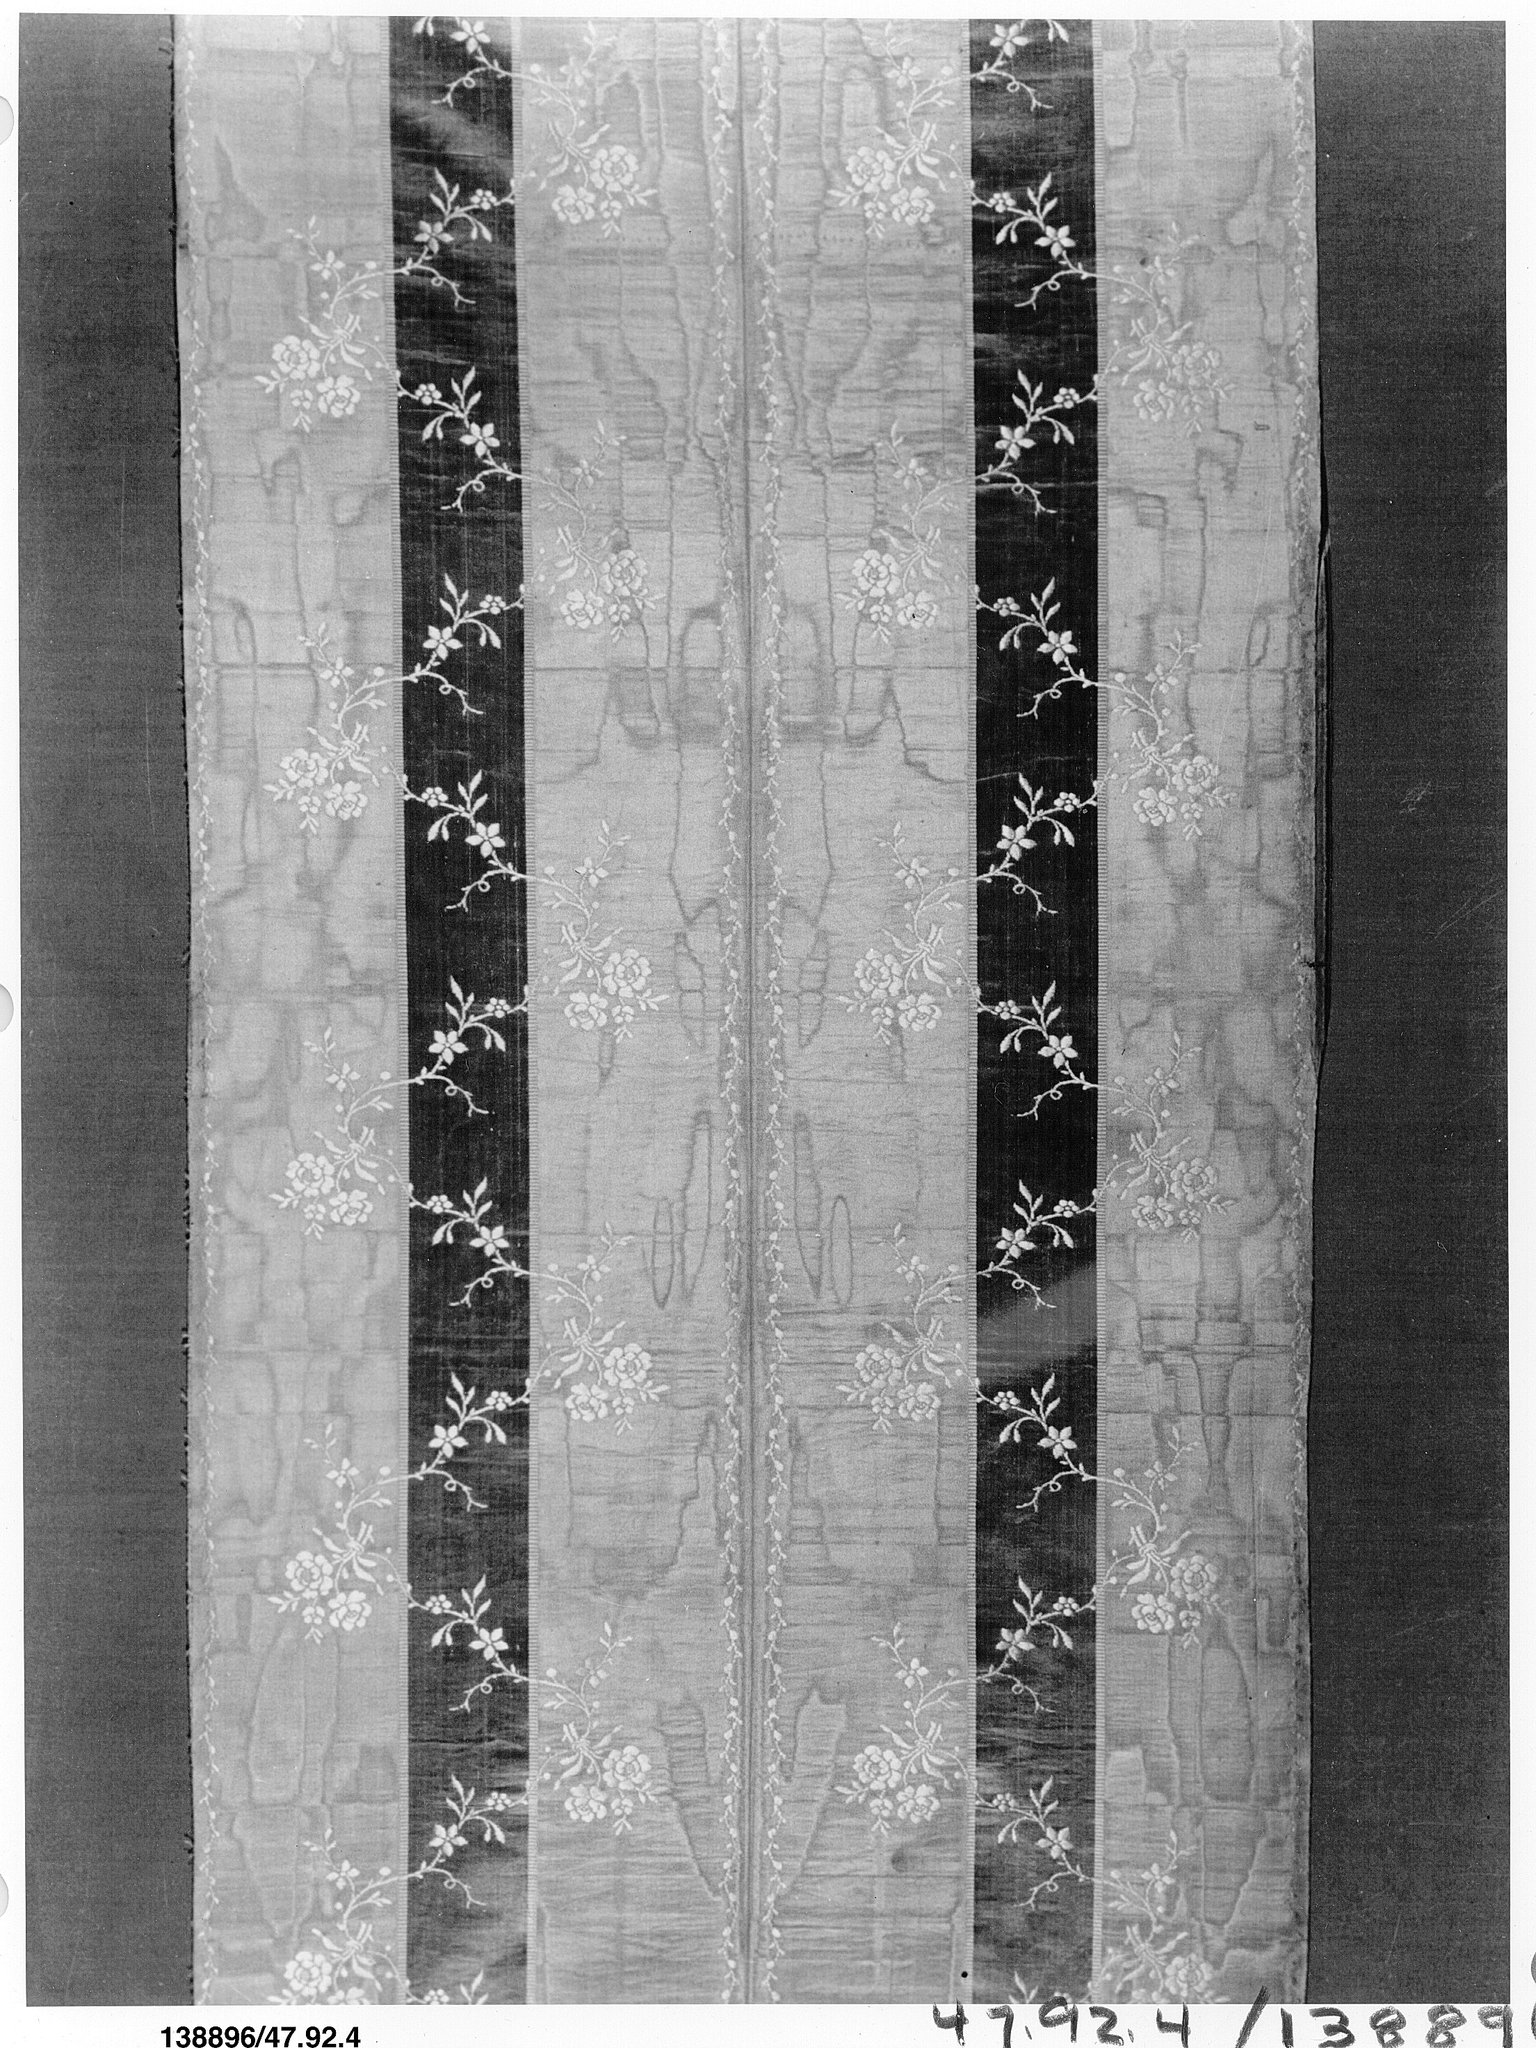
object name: piece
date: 1780-1790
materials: silk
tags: flowers,leaves